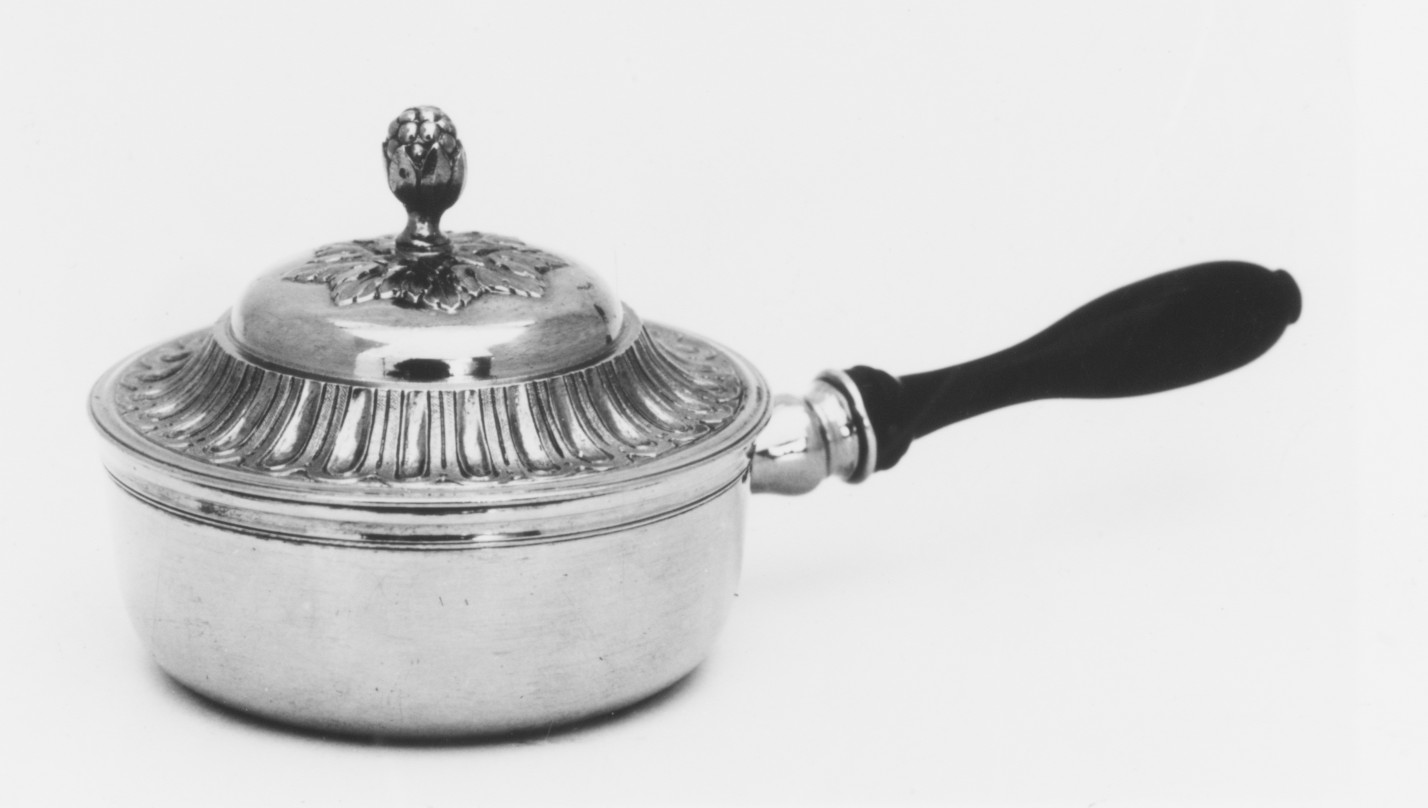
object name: casserole with cover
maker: pierre-françois goguelye (or gogly)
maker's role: maker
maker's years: 1738-1823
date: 1778-1779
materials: wood, silver gilt